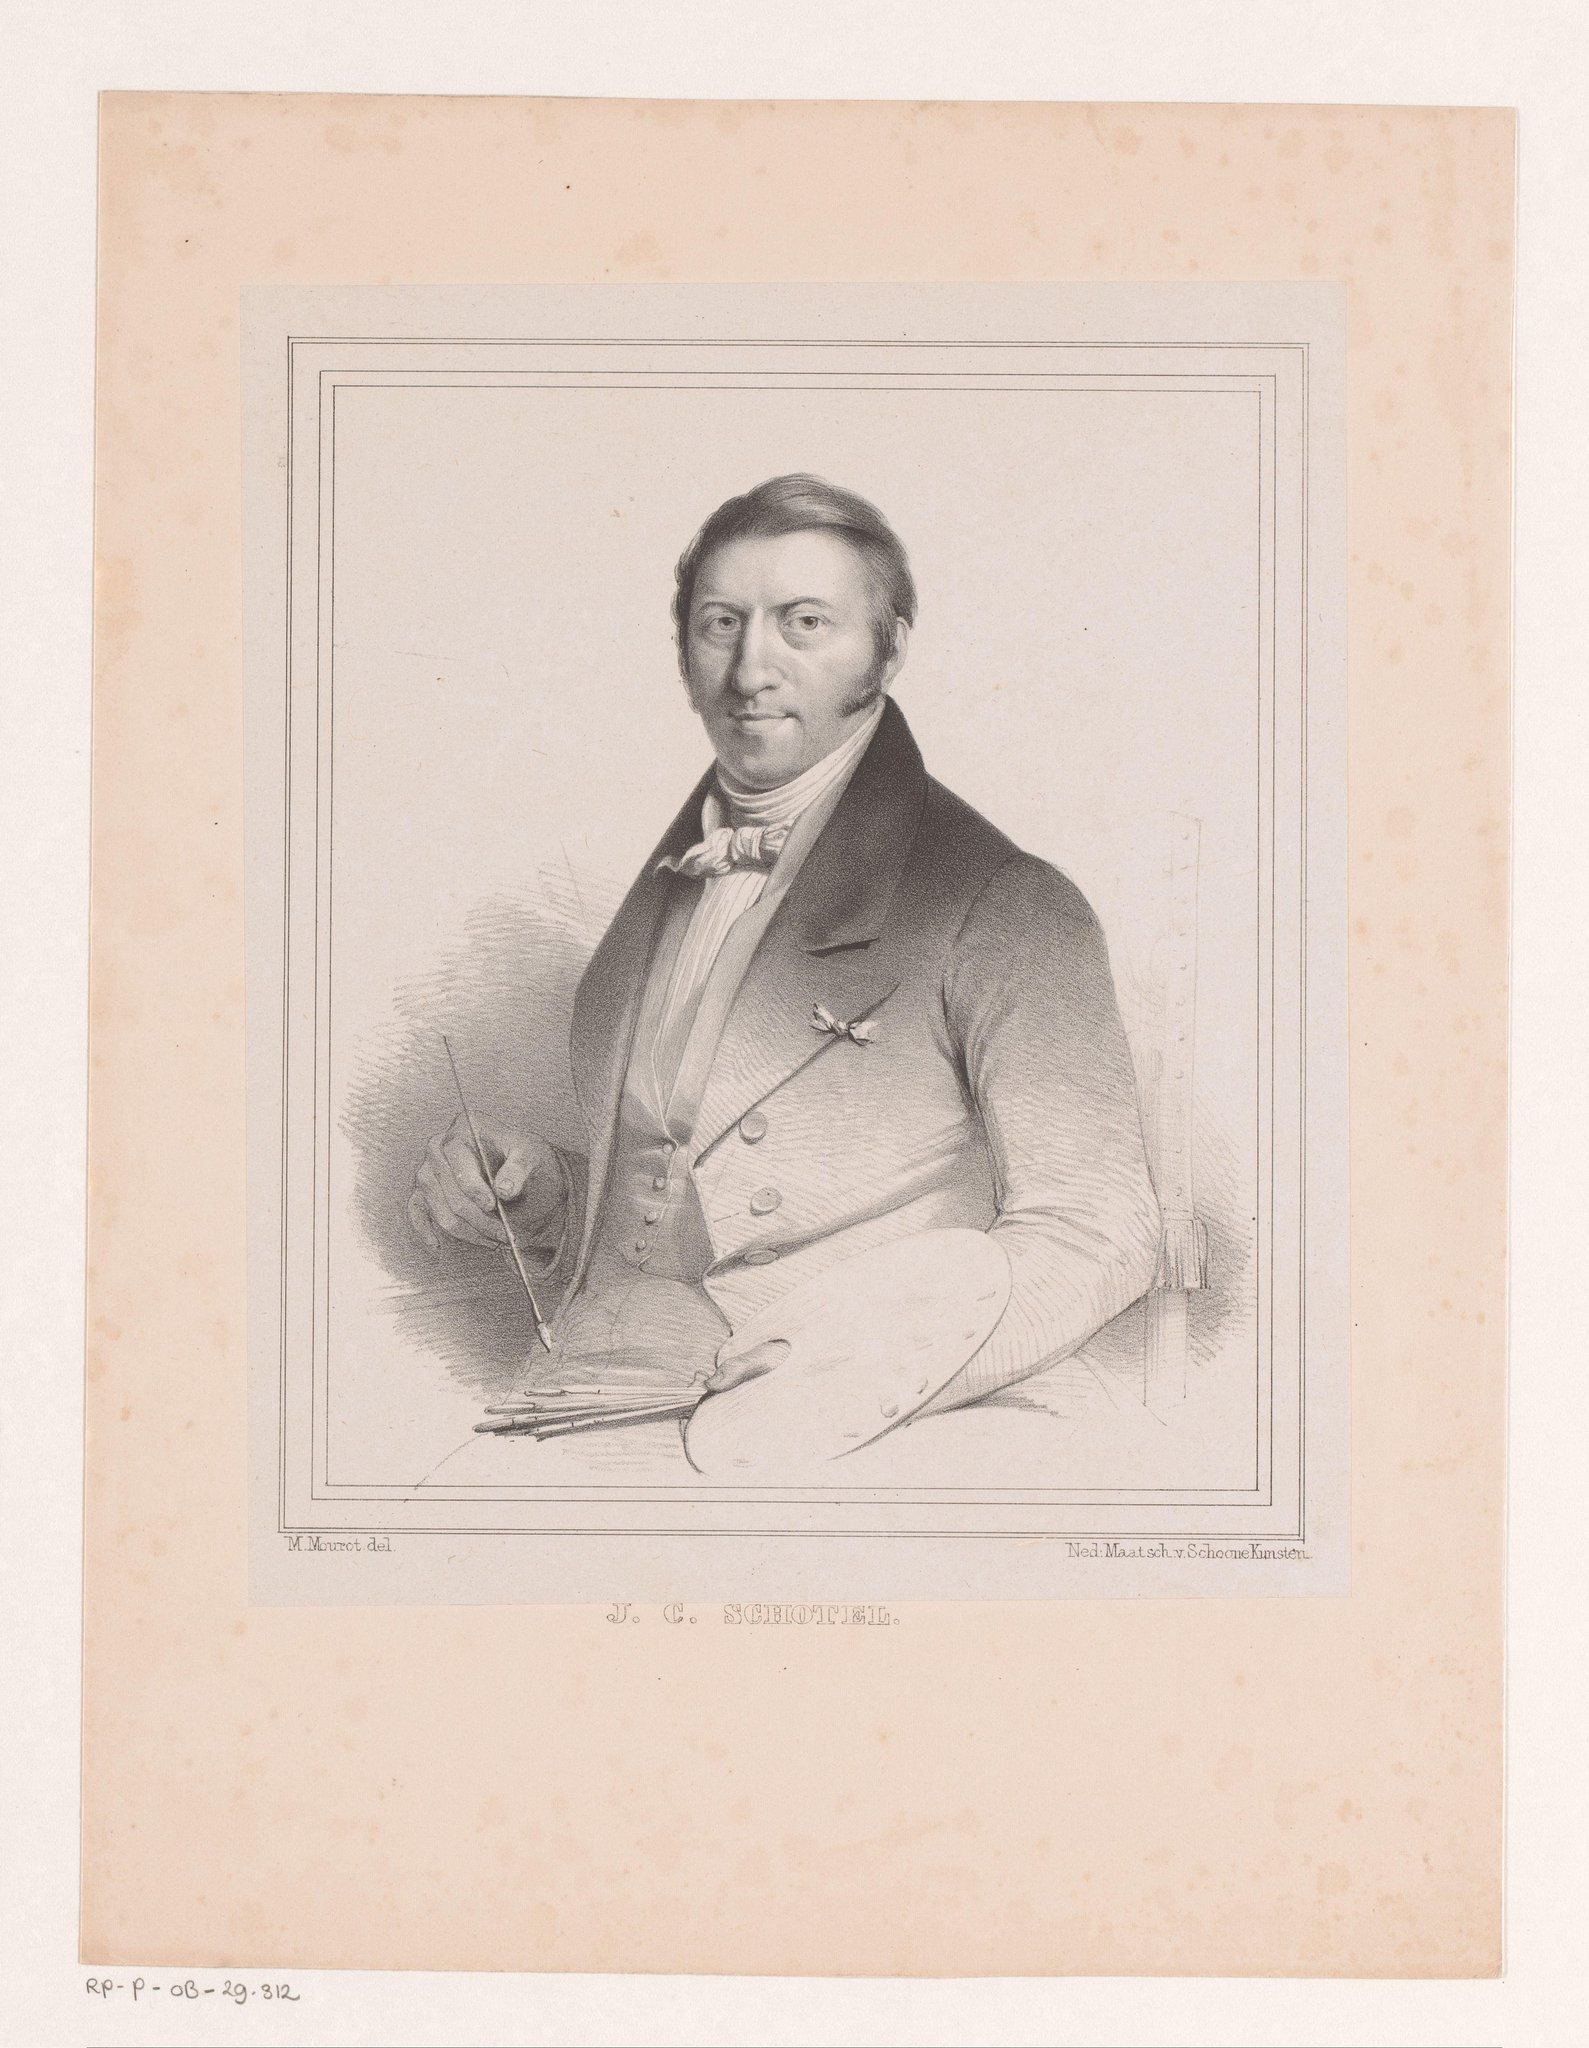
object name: print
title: Portret van Johannes Christiaan Schotel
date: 1840-1843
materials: paper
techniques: lithograph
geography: the hague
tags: dordrecht, painter, print maker, draughtsman, johannes christiaan schotel, portrait, self-portrait of artist, palette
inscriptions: collector's mark: Lugt 2228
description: De geportretteerde heeft een palet en kasten in zijn handen.